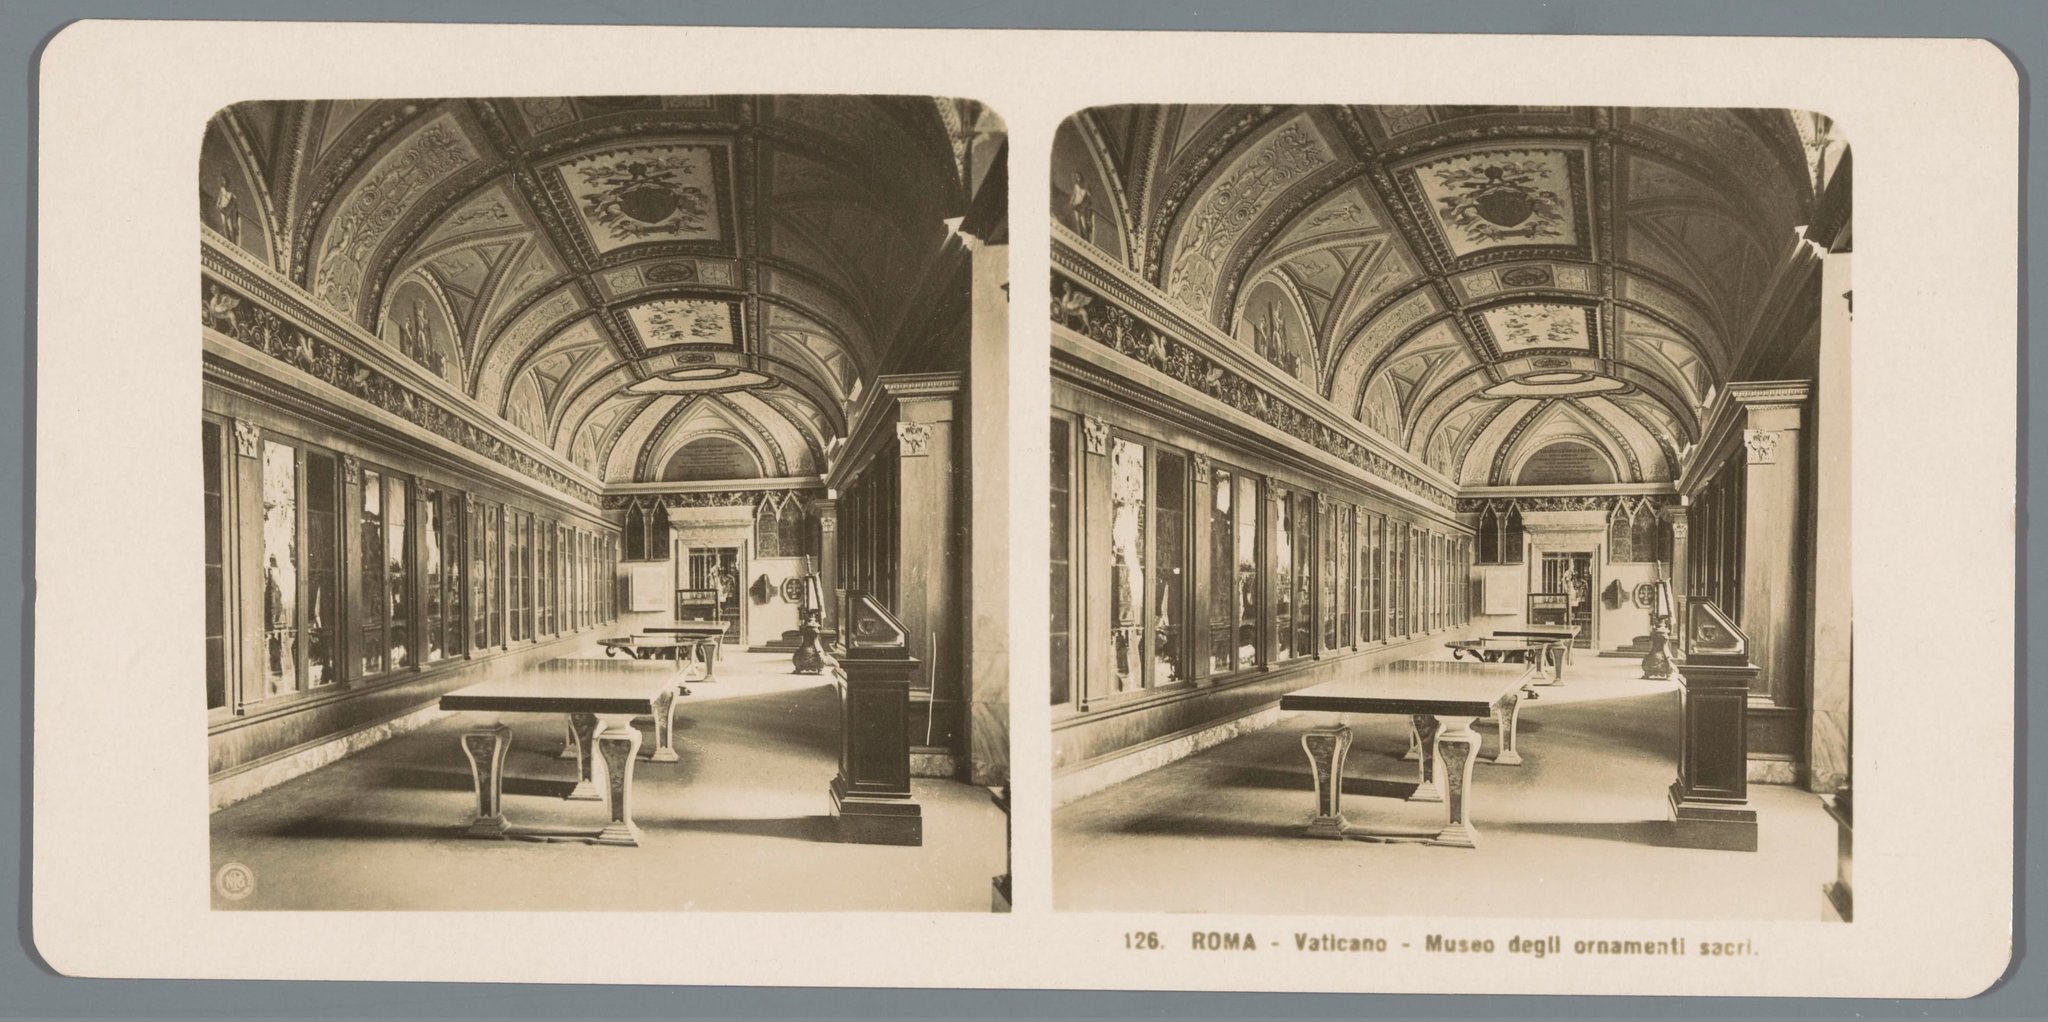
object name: stereograph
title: Roma - Vaticano - museo degli ornamenti sacri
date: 1900-1910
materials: cardboard, photographic support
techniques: gelatin silver print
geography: vatican city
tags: permanent exhibition, museum, interior ~ representation of a building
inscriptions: inscription: ‘NPG’, number: ‘126’